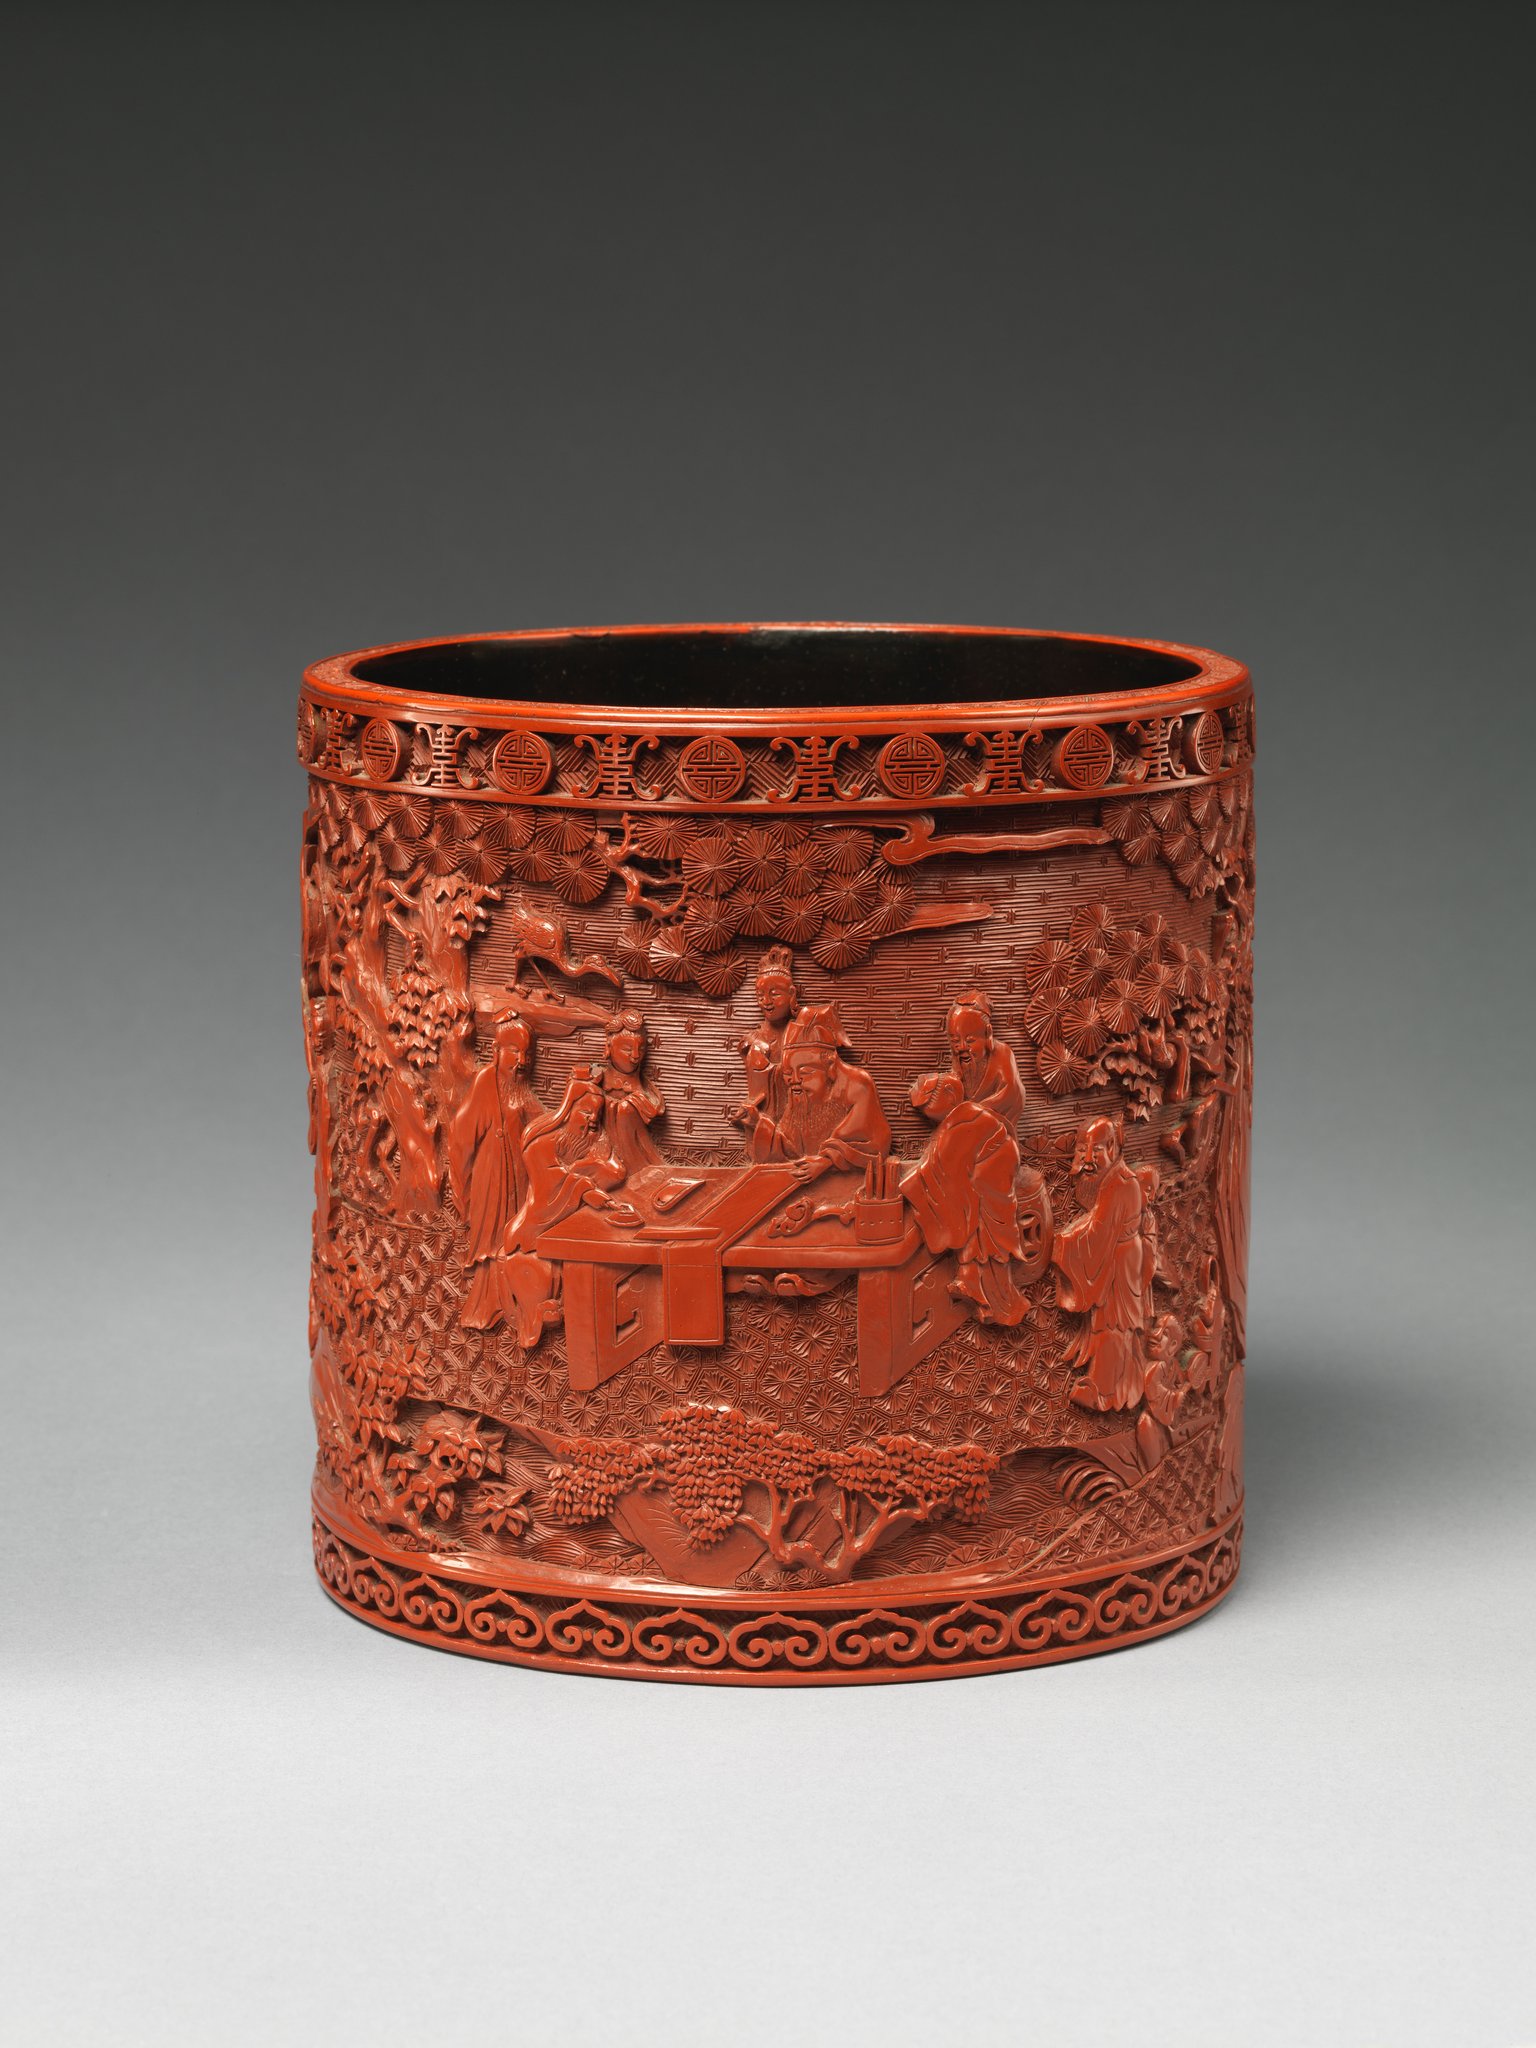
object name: brush holder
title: Brush holder with scholars in a garden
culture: chinese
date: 1701-1800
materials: lacquer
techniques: carving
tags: birds,men,writing